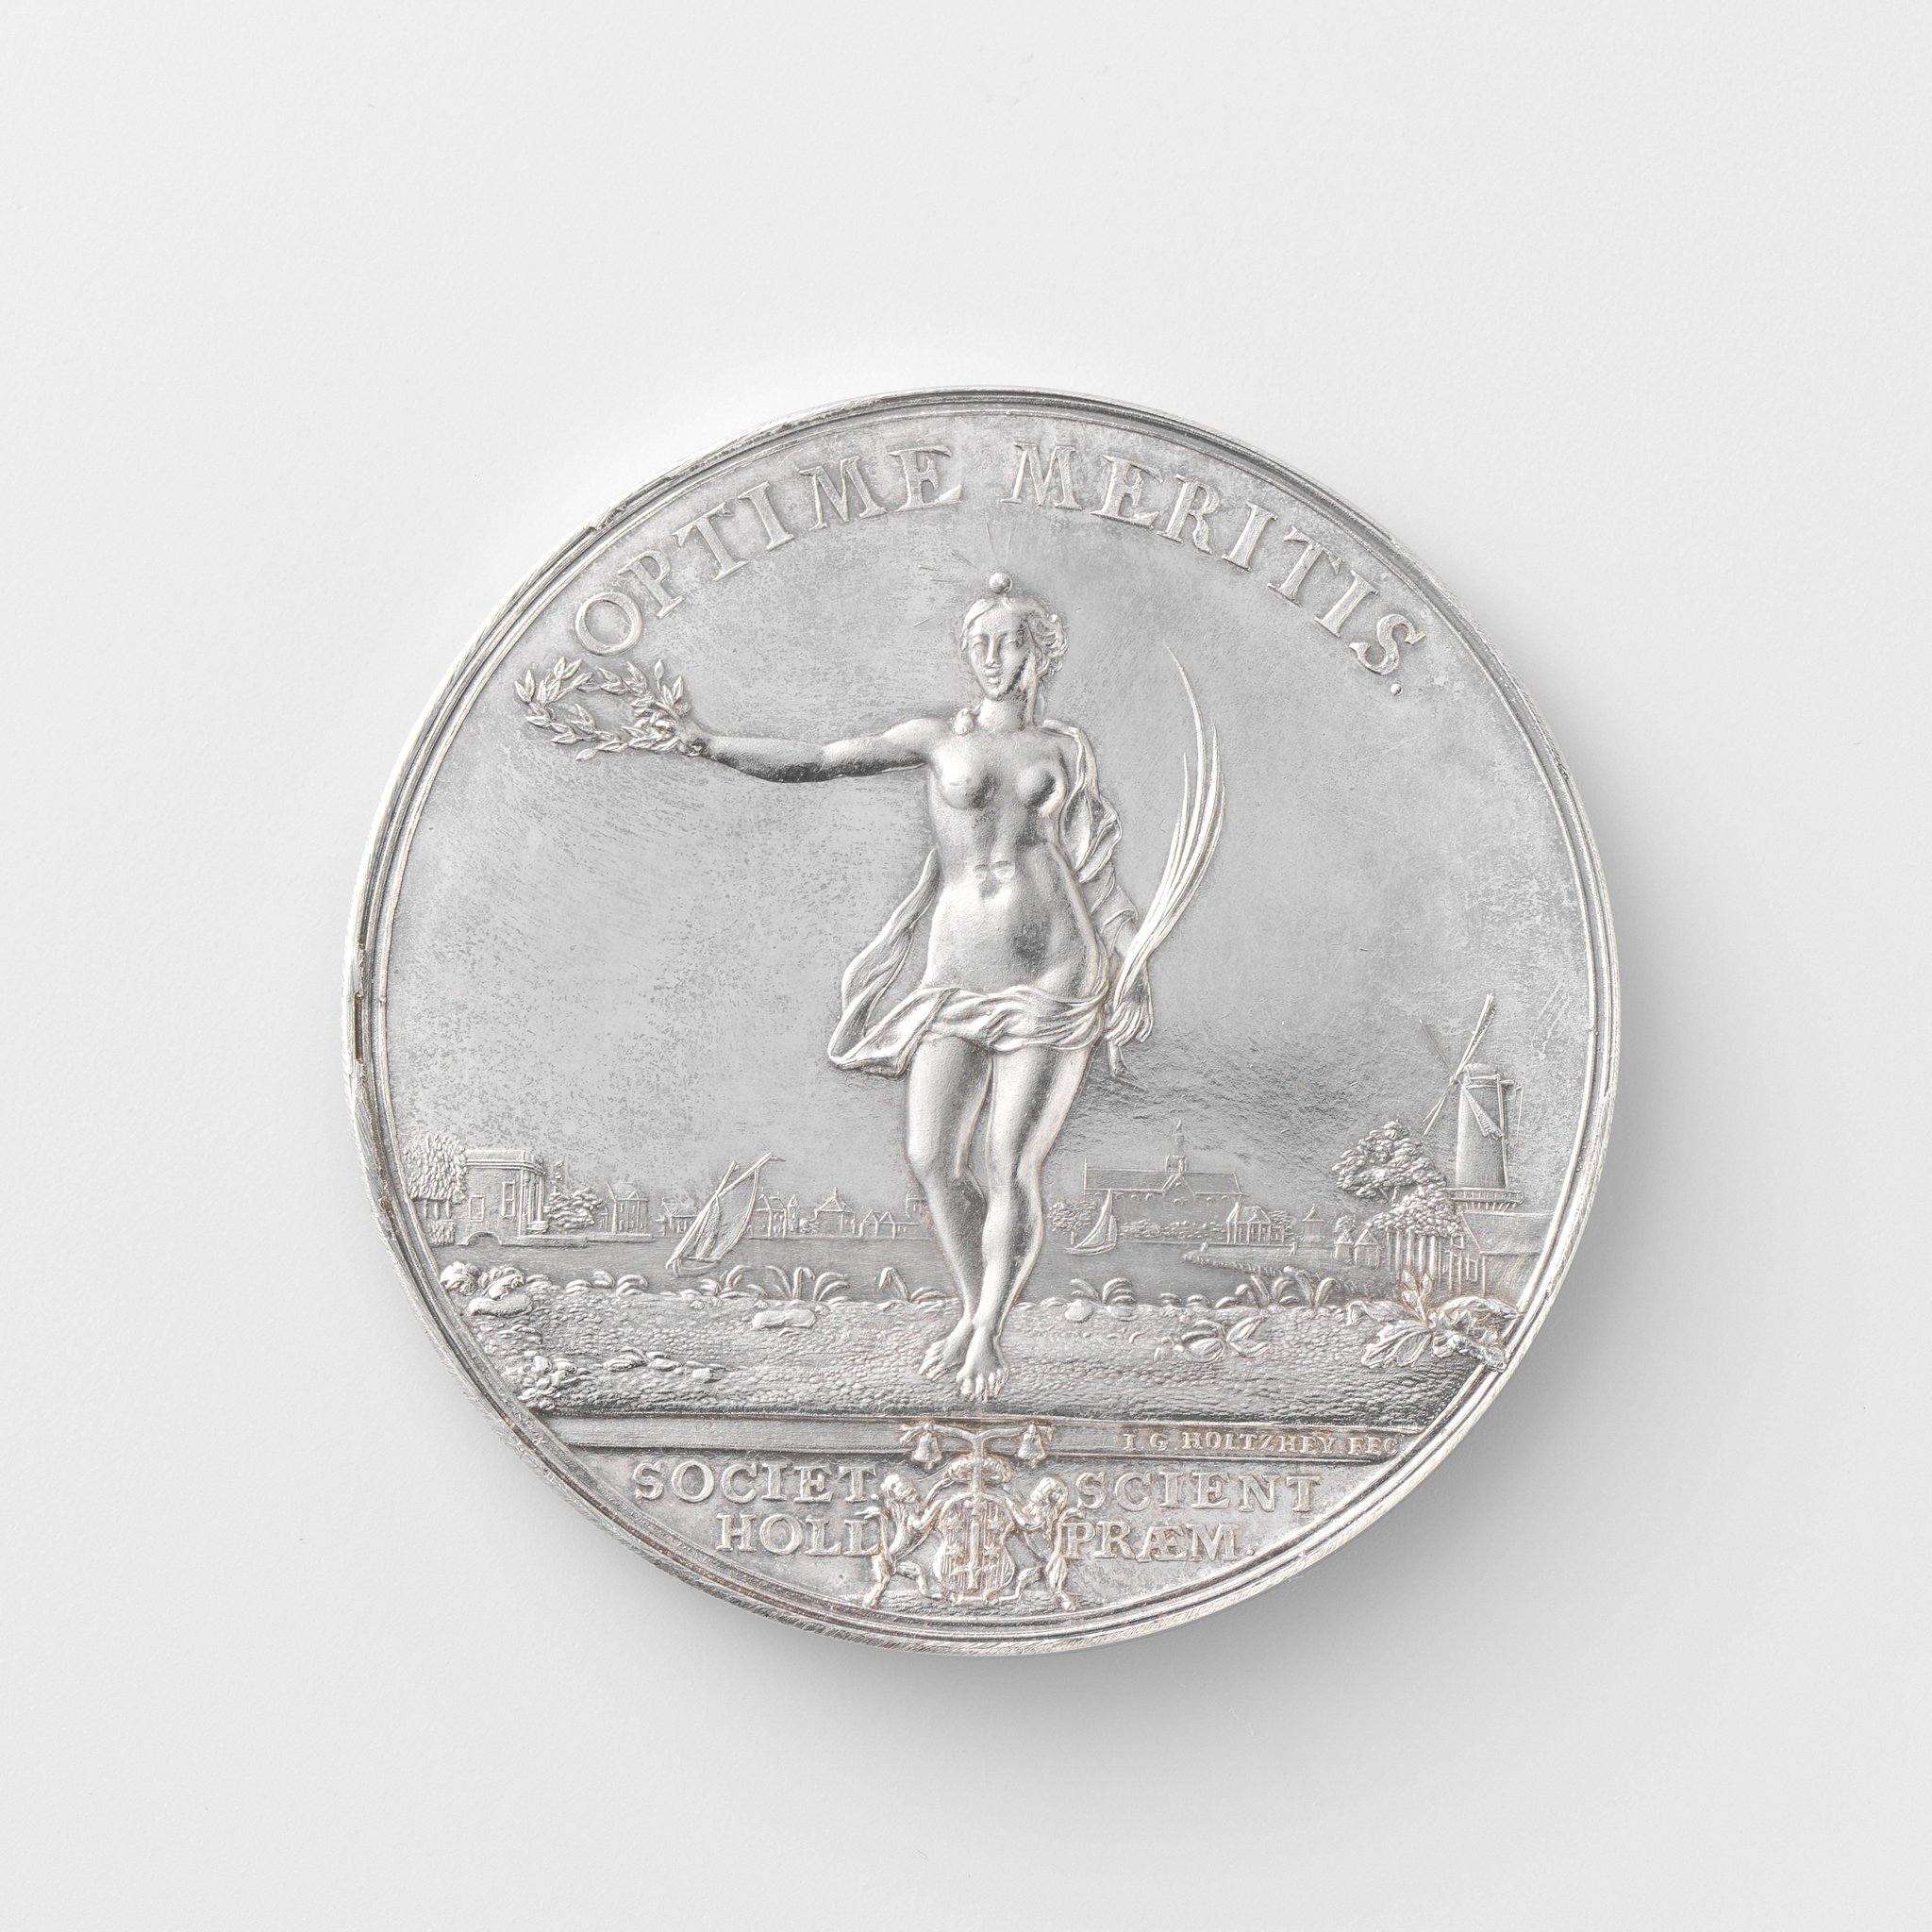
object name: medal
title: Hollandsche Maatschappij der Wetenschappen te Haarlem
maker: johan george holtzhey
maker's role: mintmaster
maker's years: 1726-1808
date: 1752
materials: silver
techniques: striking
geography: amsterdam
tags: truth; 'verità' (ripa), haarlem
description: Medal silver, by J.G. Holtzhey, 1752 Struck to mark the founding of the scientific society, the Hollandsche Maatschappij van Wetenschappen in Haarlem in 1752. This was the Republic's first national scholarly society. The society focused on every aspect of science.